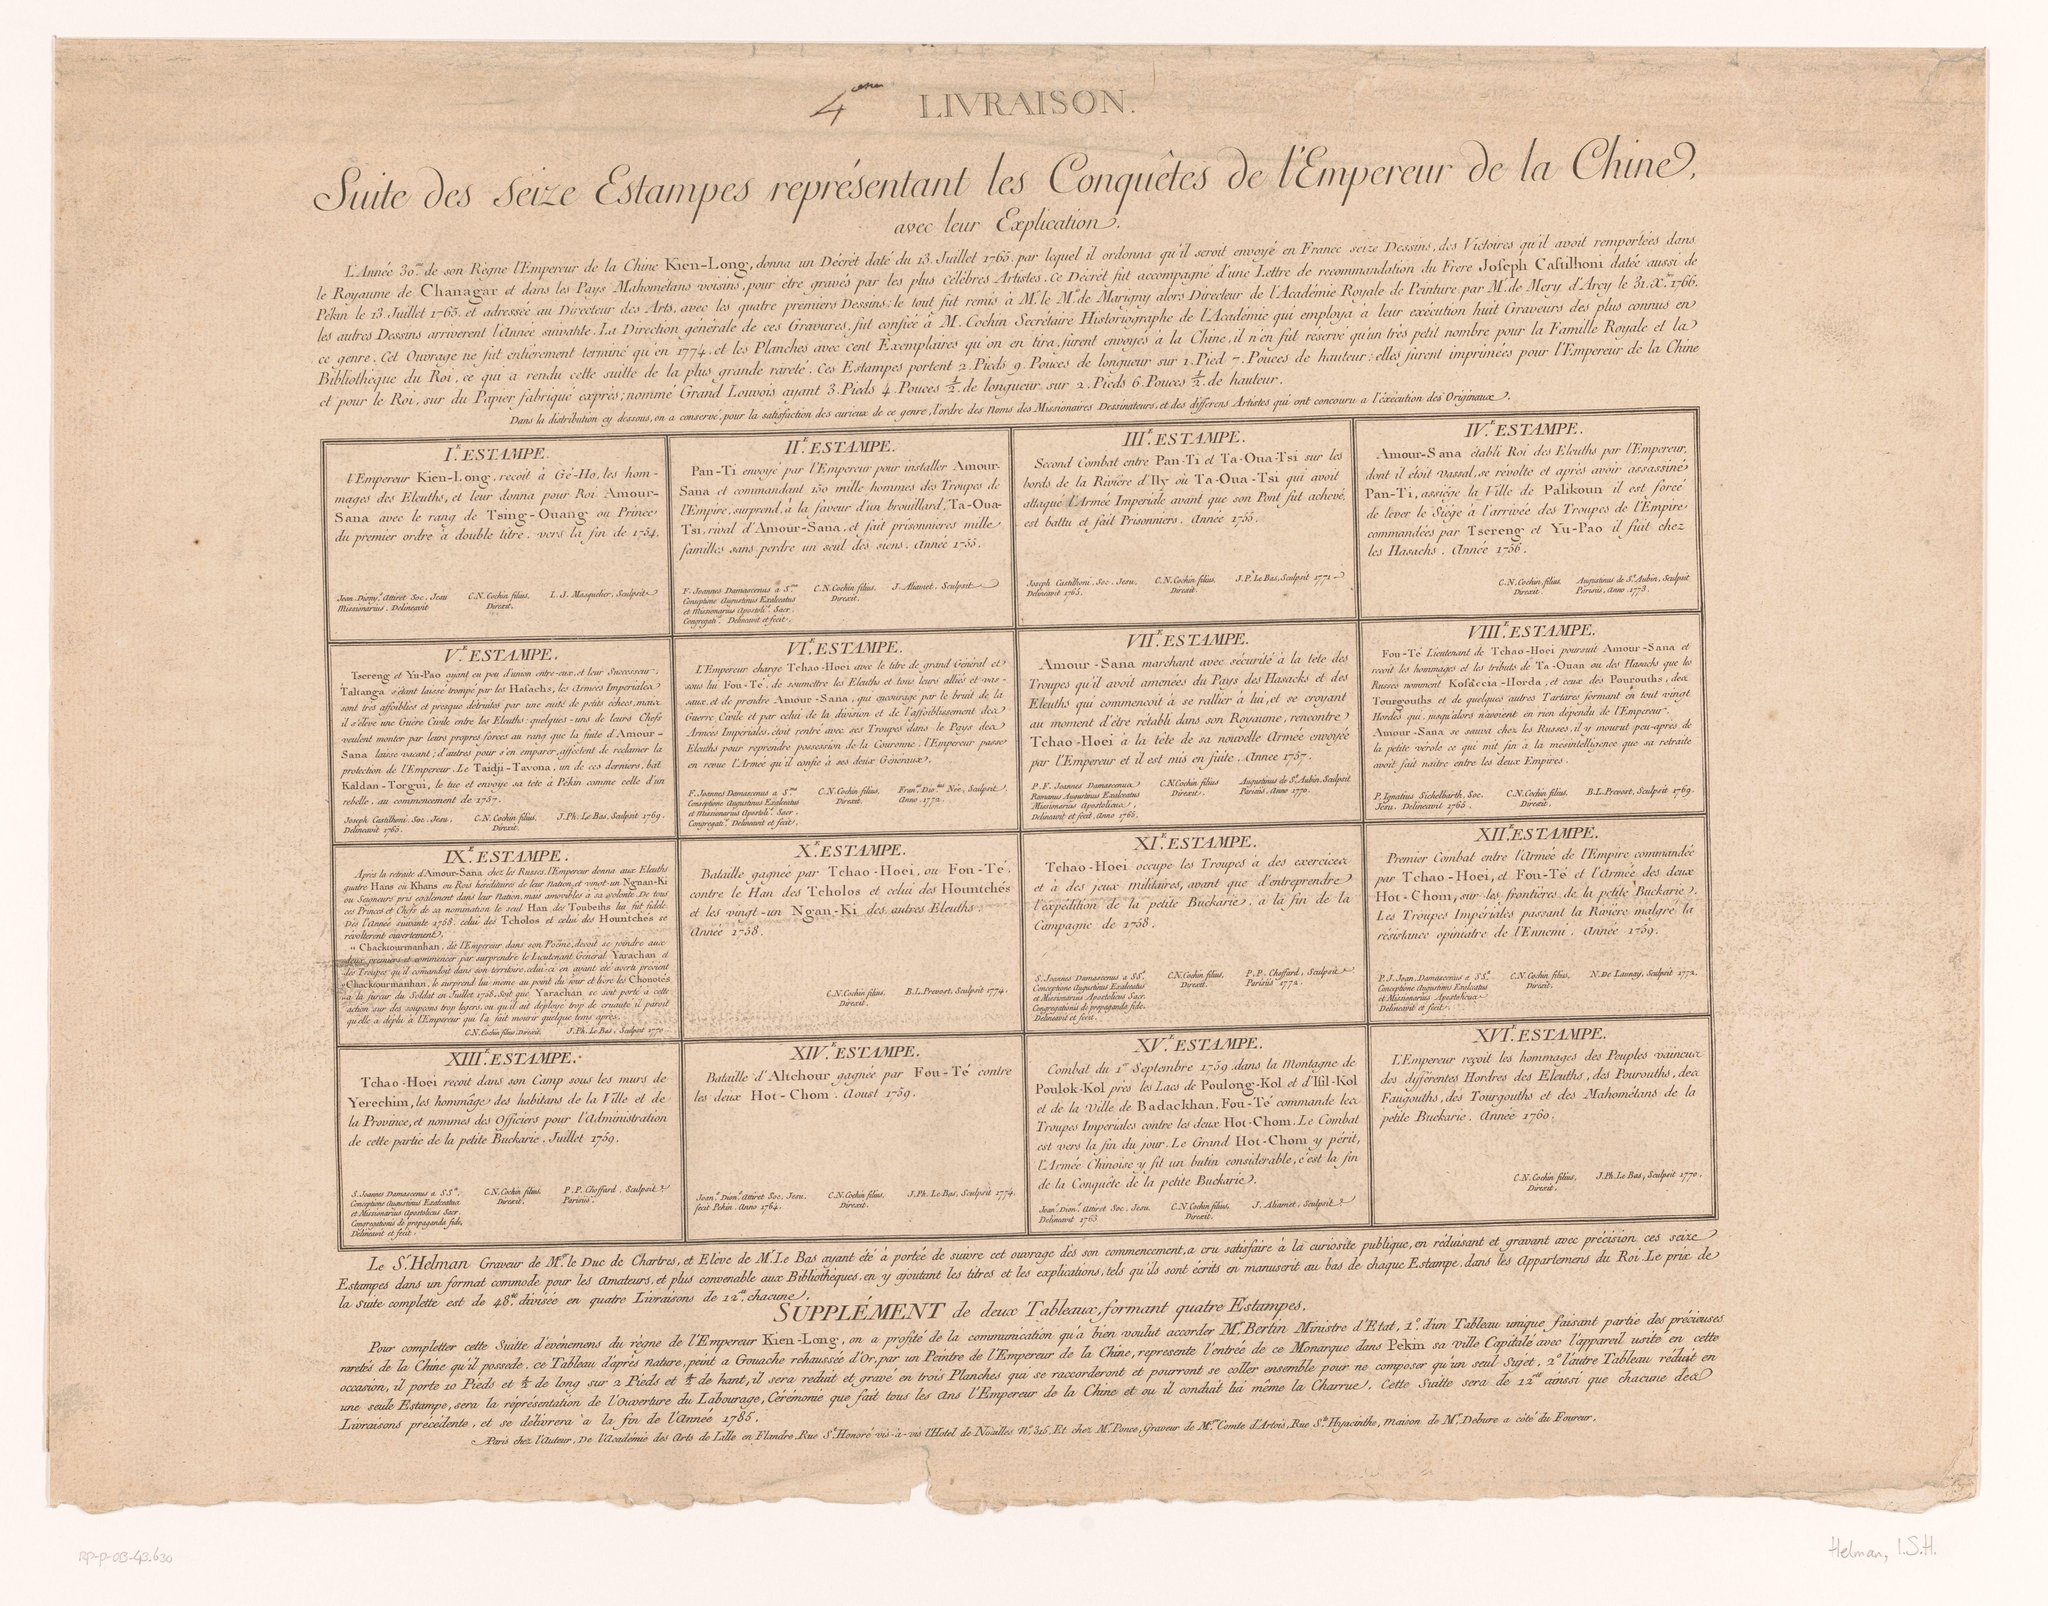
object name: print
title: Conquêtes de l'Empereur de la Chine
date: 1783-1785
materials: paper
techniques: engraving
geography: france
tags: letters, alphabet, script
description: Beschrijvende tekst bij een versie van de serie 'Conquêtes de l' Empereur de la Chine' met afbeeldingen van de veroveringen van keizer Qianlong van China, uitgegeven door Helman tussen 1783-1785.